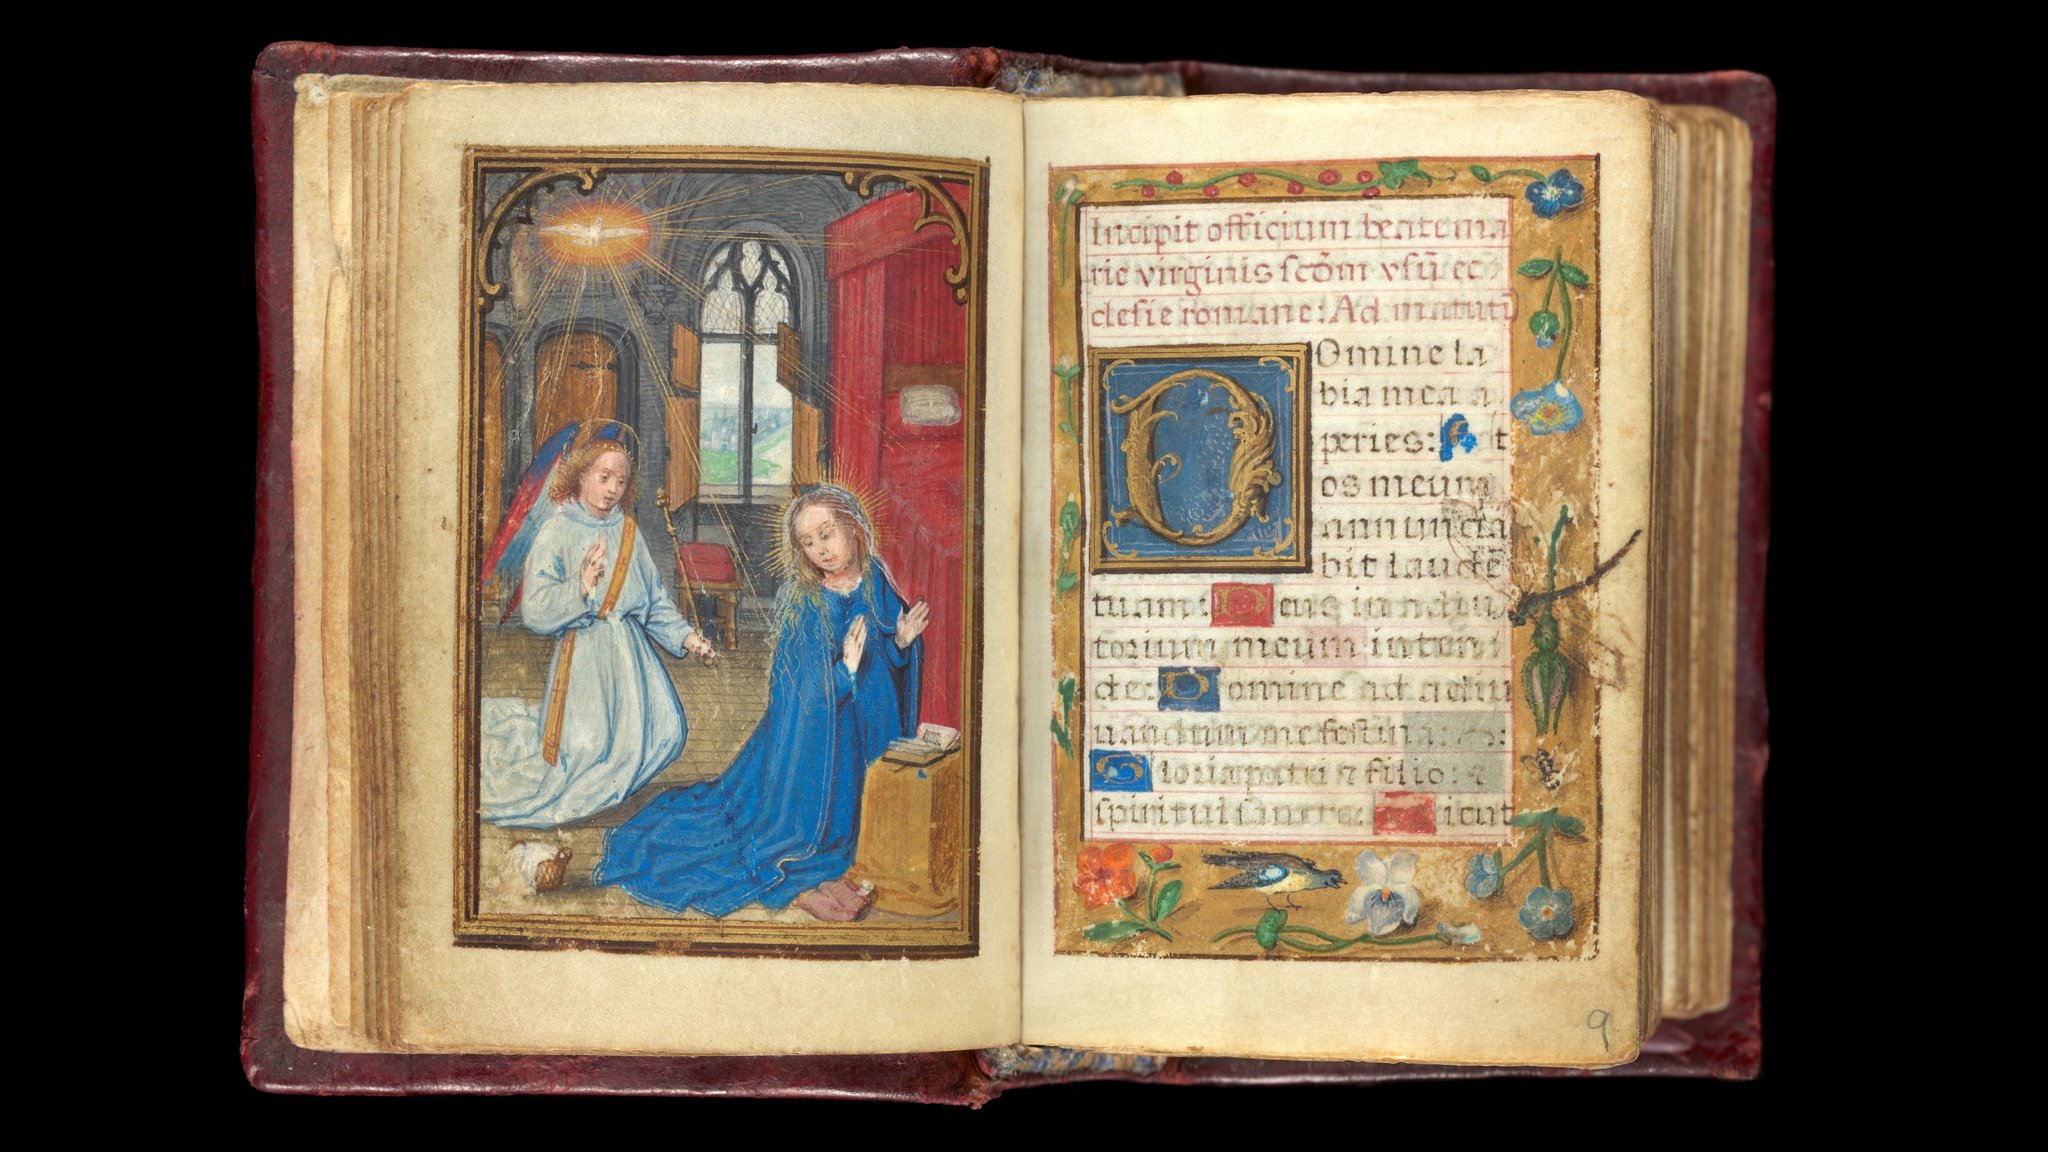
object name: manuscript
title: Book of Hours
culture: dutch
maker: simon bening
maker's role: artist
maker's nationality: netherlandish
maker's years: 1483-1561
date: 1530-1535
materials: gold, ink, leather, parchment, paint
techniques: bookbinding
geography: belgium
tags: men,women,cows,dogs,horses,sheep,holy family,jesus,annunciation,nativity,working,shepherds